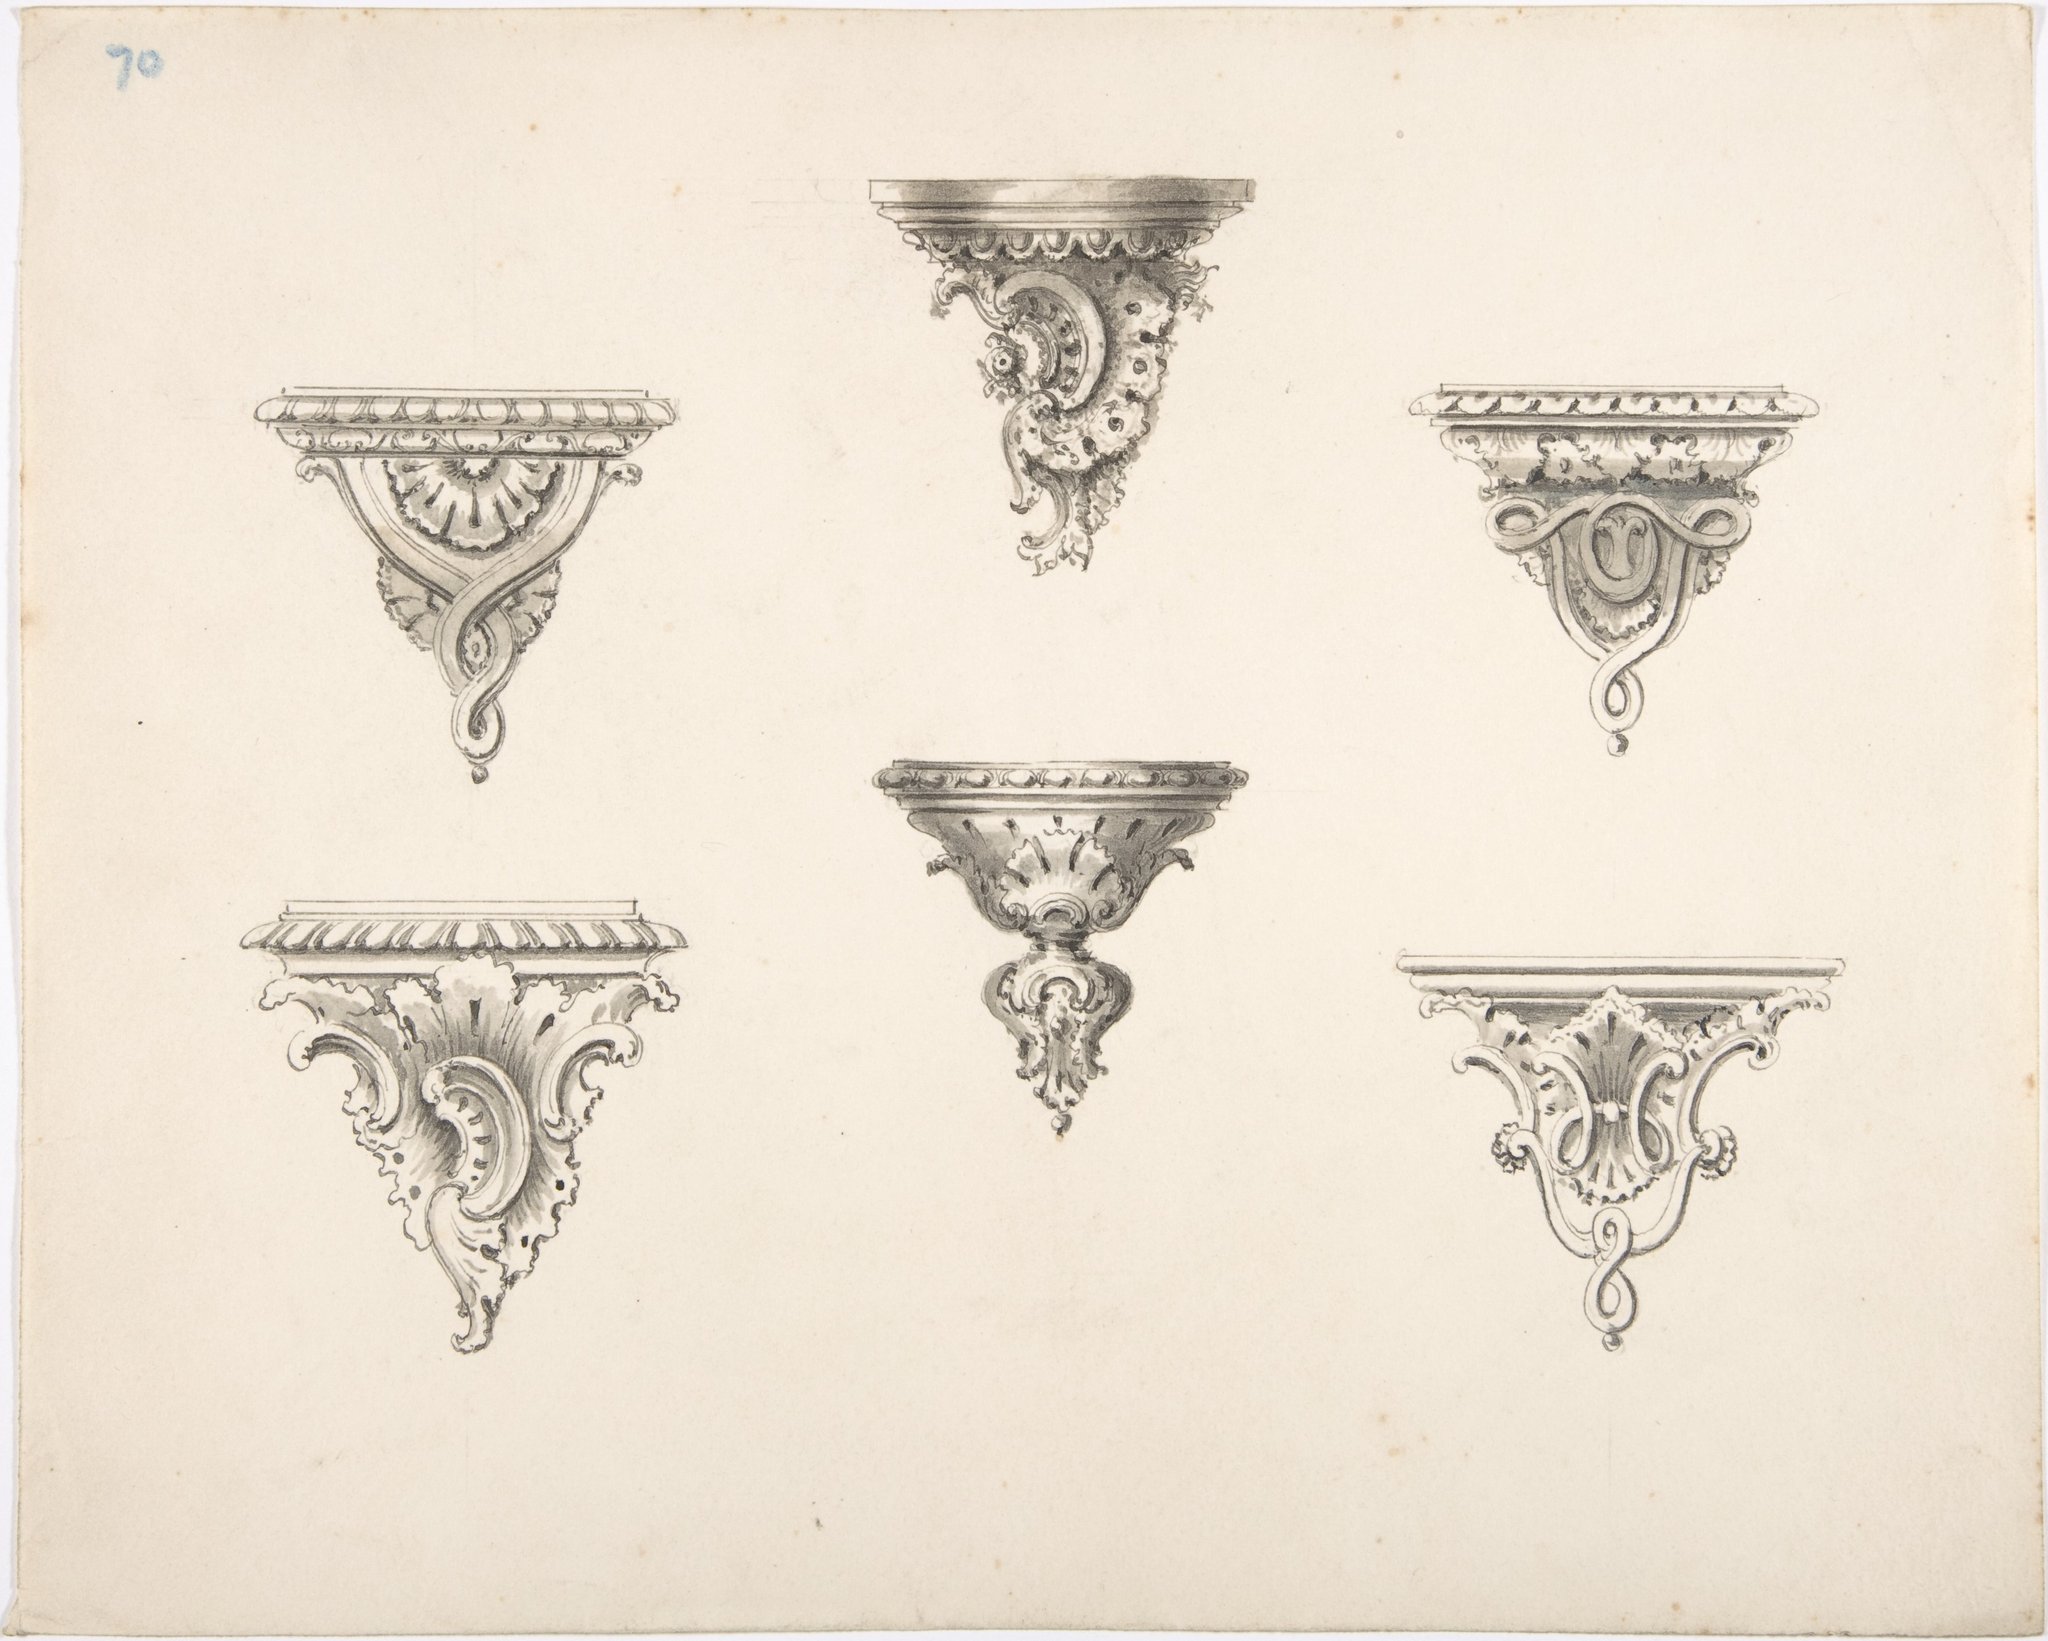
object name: drawing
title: Design for Six Brackets with Rocaille Ornament and Strapwork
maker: anonymous, british, 19th century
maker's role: artist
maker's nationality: british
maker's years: 1800-1900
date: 1801-1833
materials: ink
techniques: brush, pen, wash